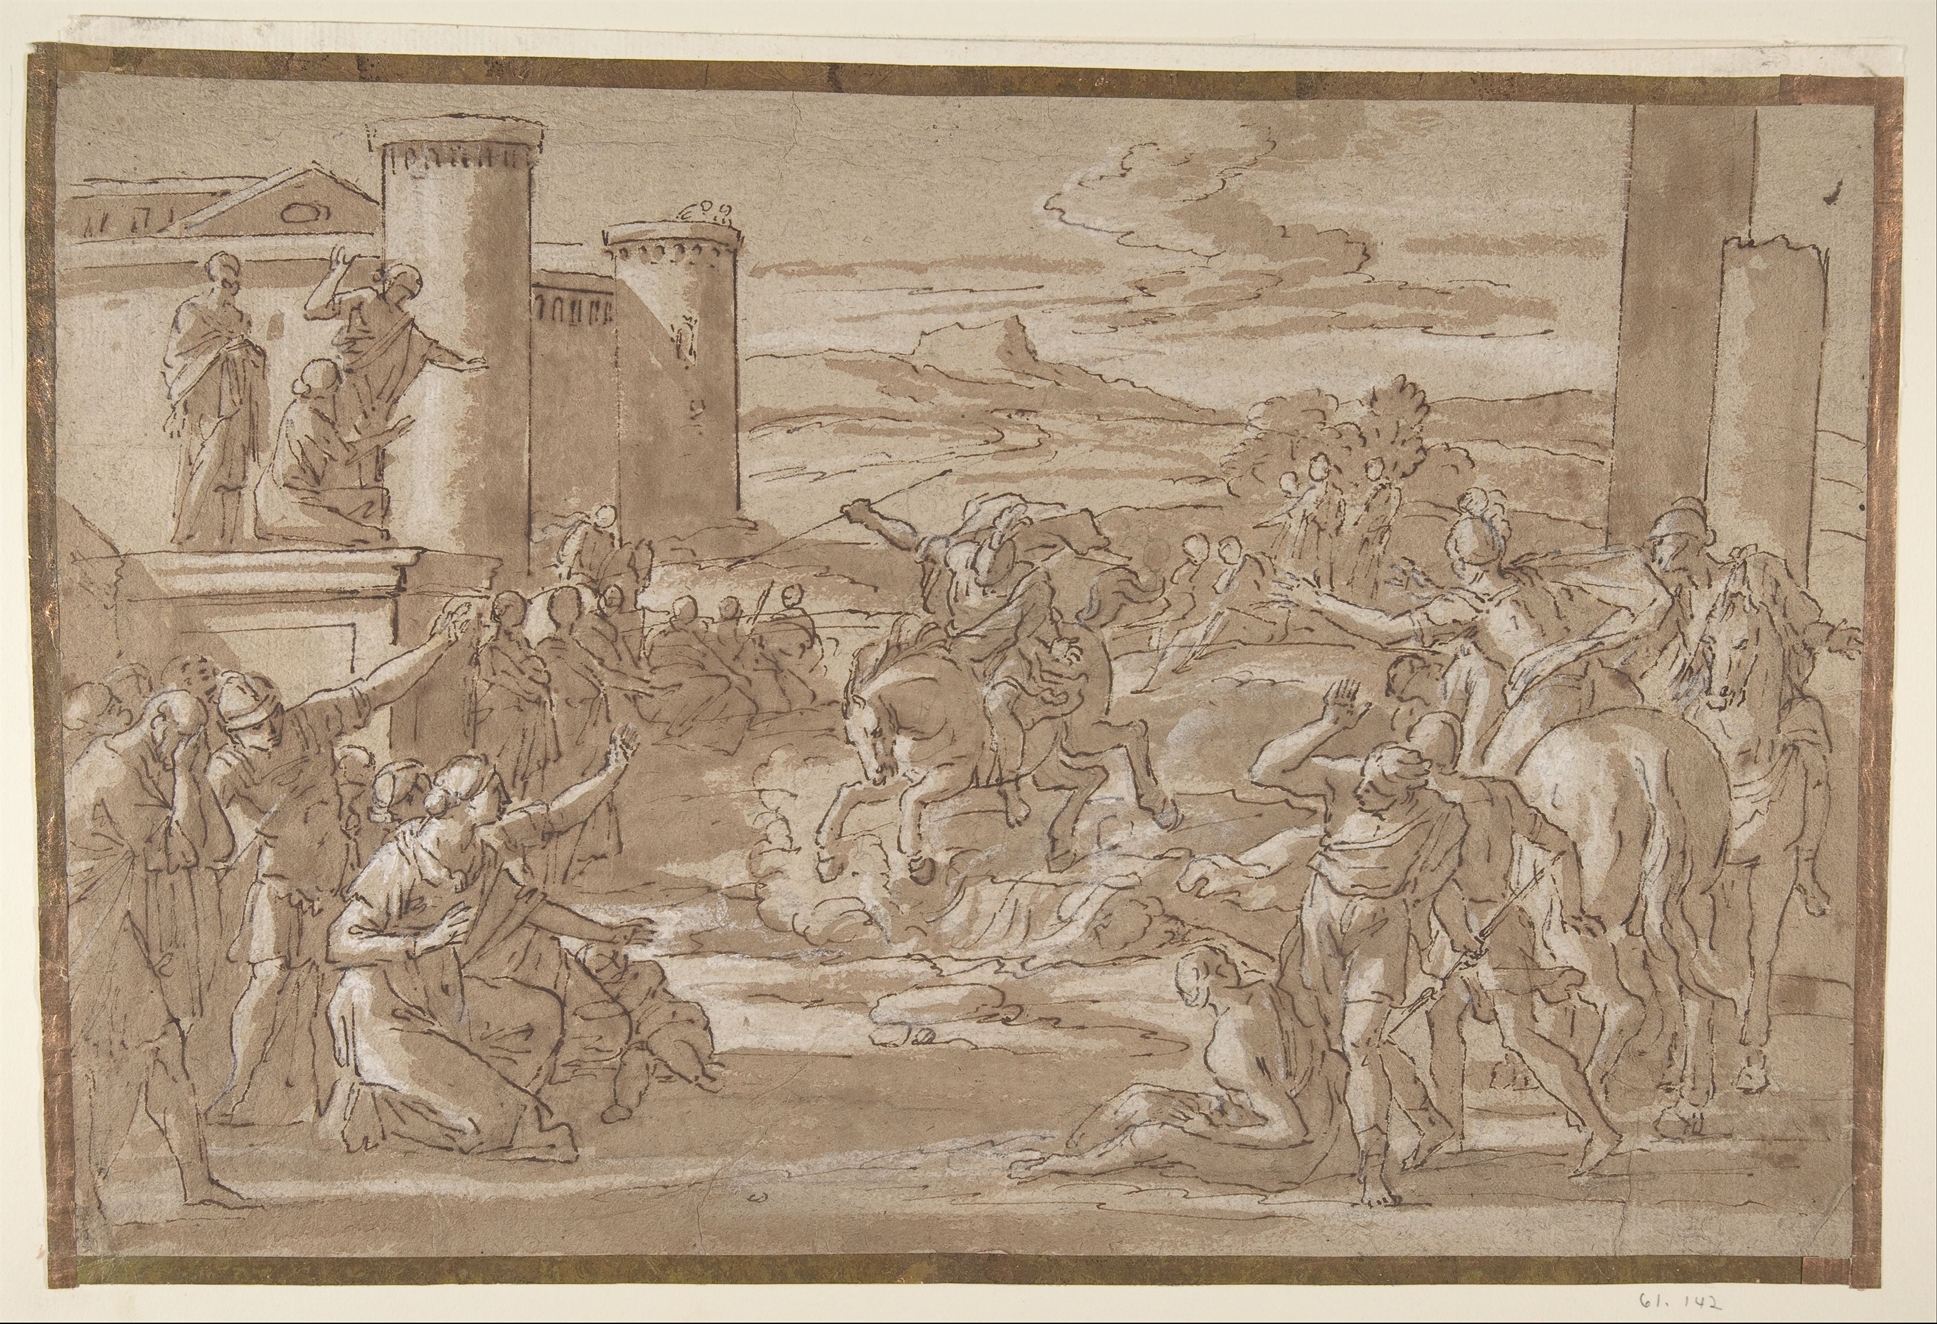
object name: drawing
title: Marcus Curtius Leaping into the Chasm (recto); Study of a Seated Crowned Female Figure (verso)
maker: luigi garzi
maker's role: artist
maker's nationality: italian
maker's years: 1638-1721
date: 1638-1721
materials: chalk, ink, paper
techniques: brush, highlighting, pen, wash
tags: battles,men,women,horses